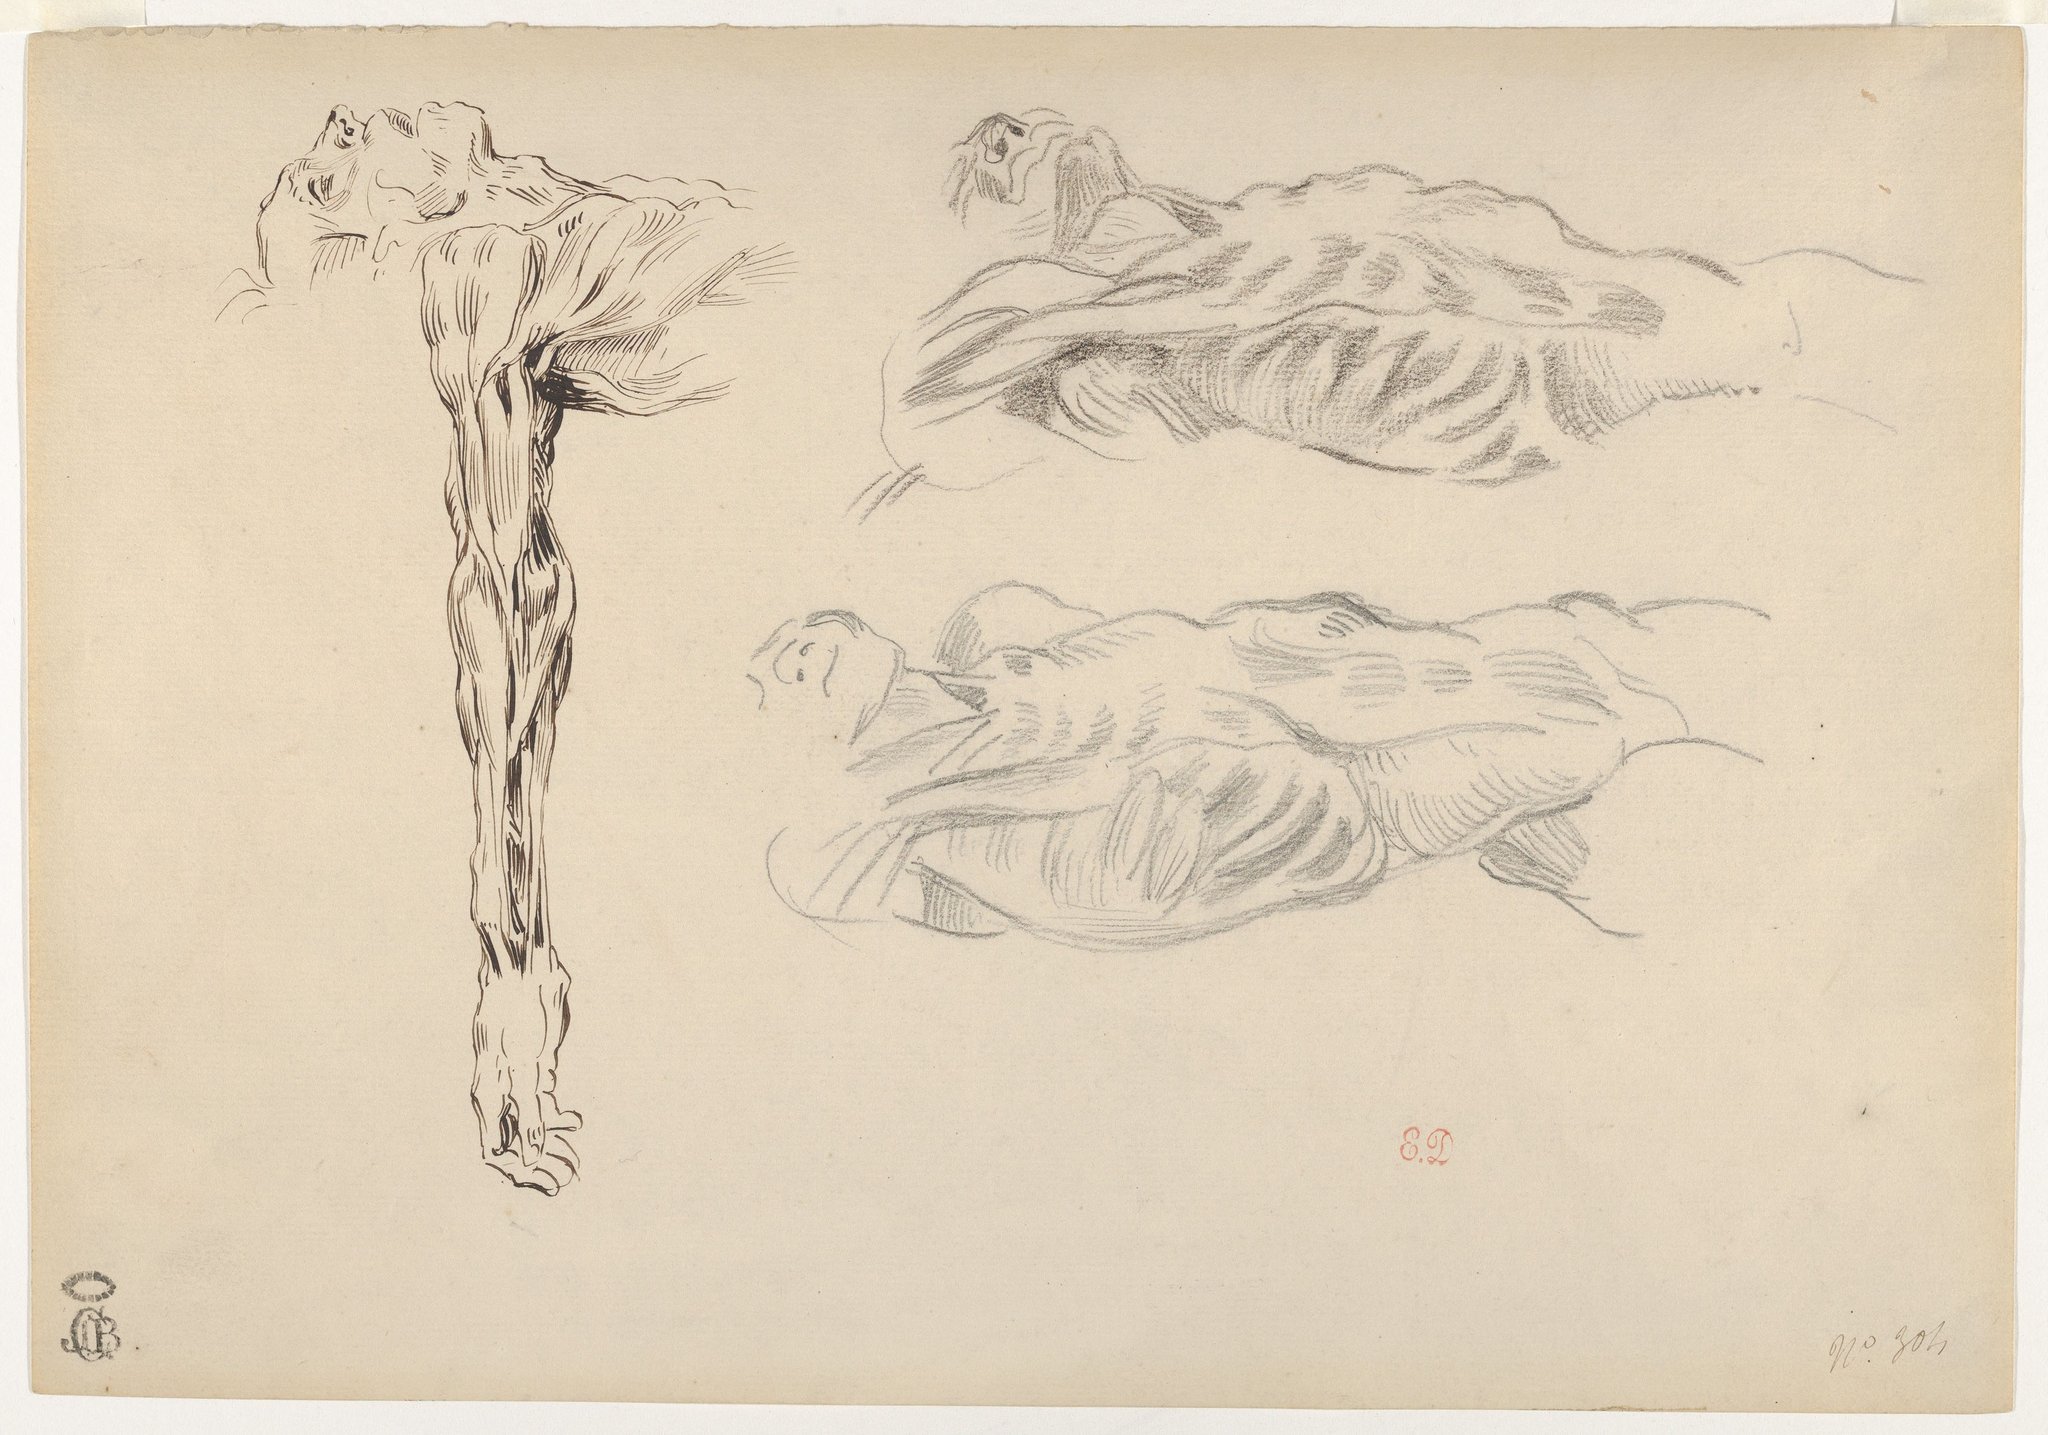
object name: drawing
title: Écorché: Three Studies of a Male Cadaver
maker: eugène delacroix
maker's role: artist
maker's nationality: french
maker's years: 1798-1863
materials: graphite, ink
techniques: pen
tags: corpses